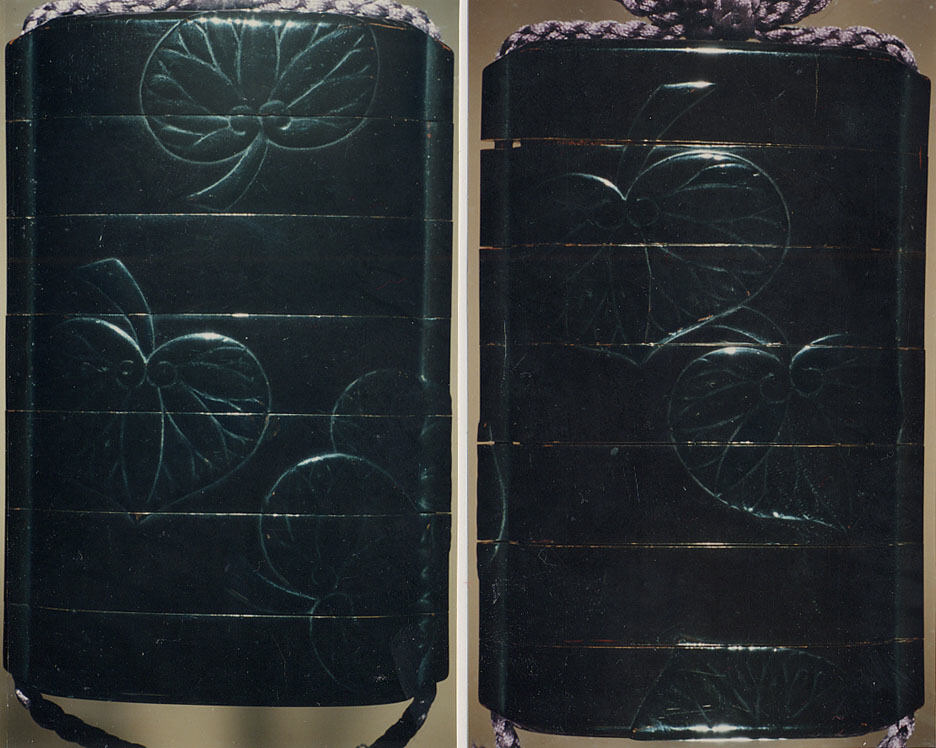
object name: inrō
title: Case (Inrō) with Design of Scattered Hollyhock (Aoi) Leaves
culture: japanese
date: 1701-1800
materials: lacquer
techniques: fundame, hiramakie, roiro